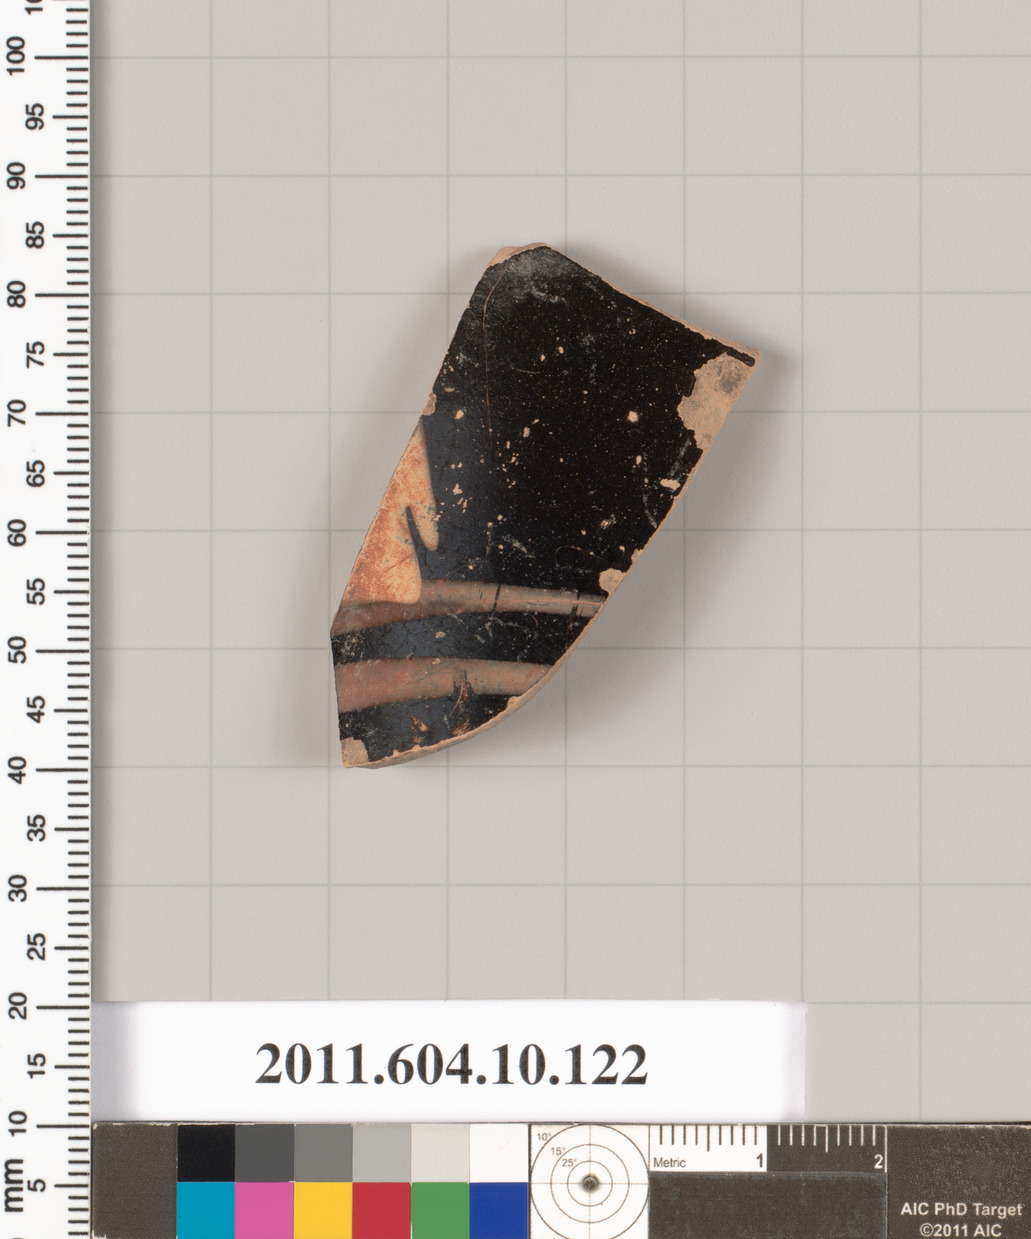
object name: undetermined closed shape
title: Terracotta fragment of a closed shape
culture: etruscan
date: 434-401 BCE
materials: terracotta